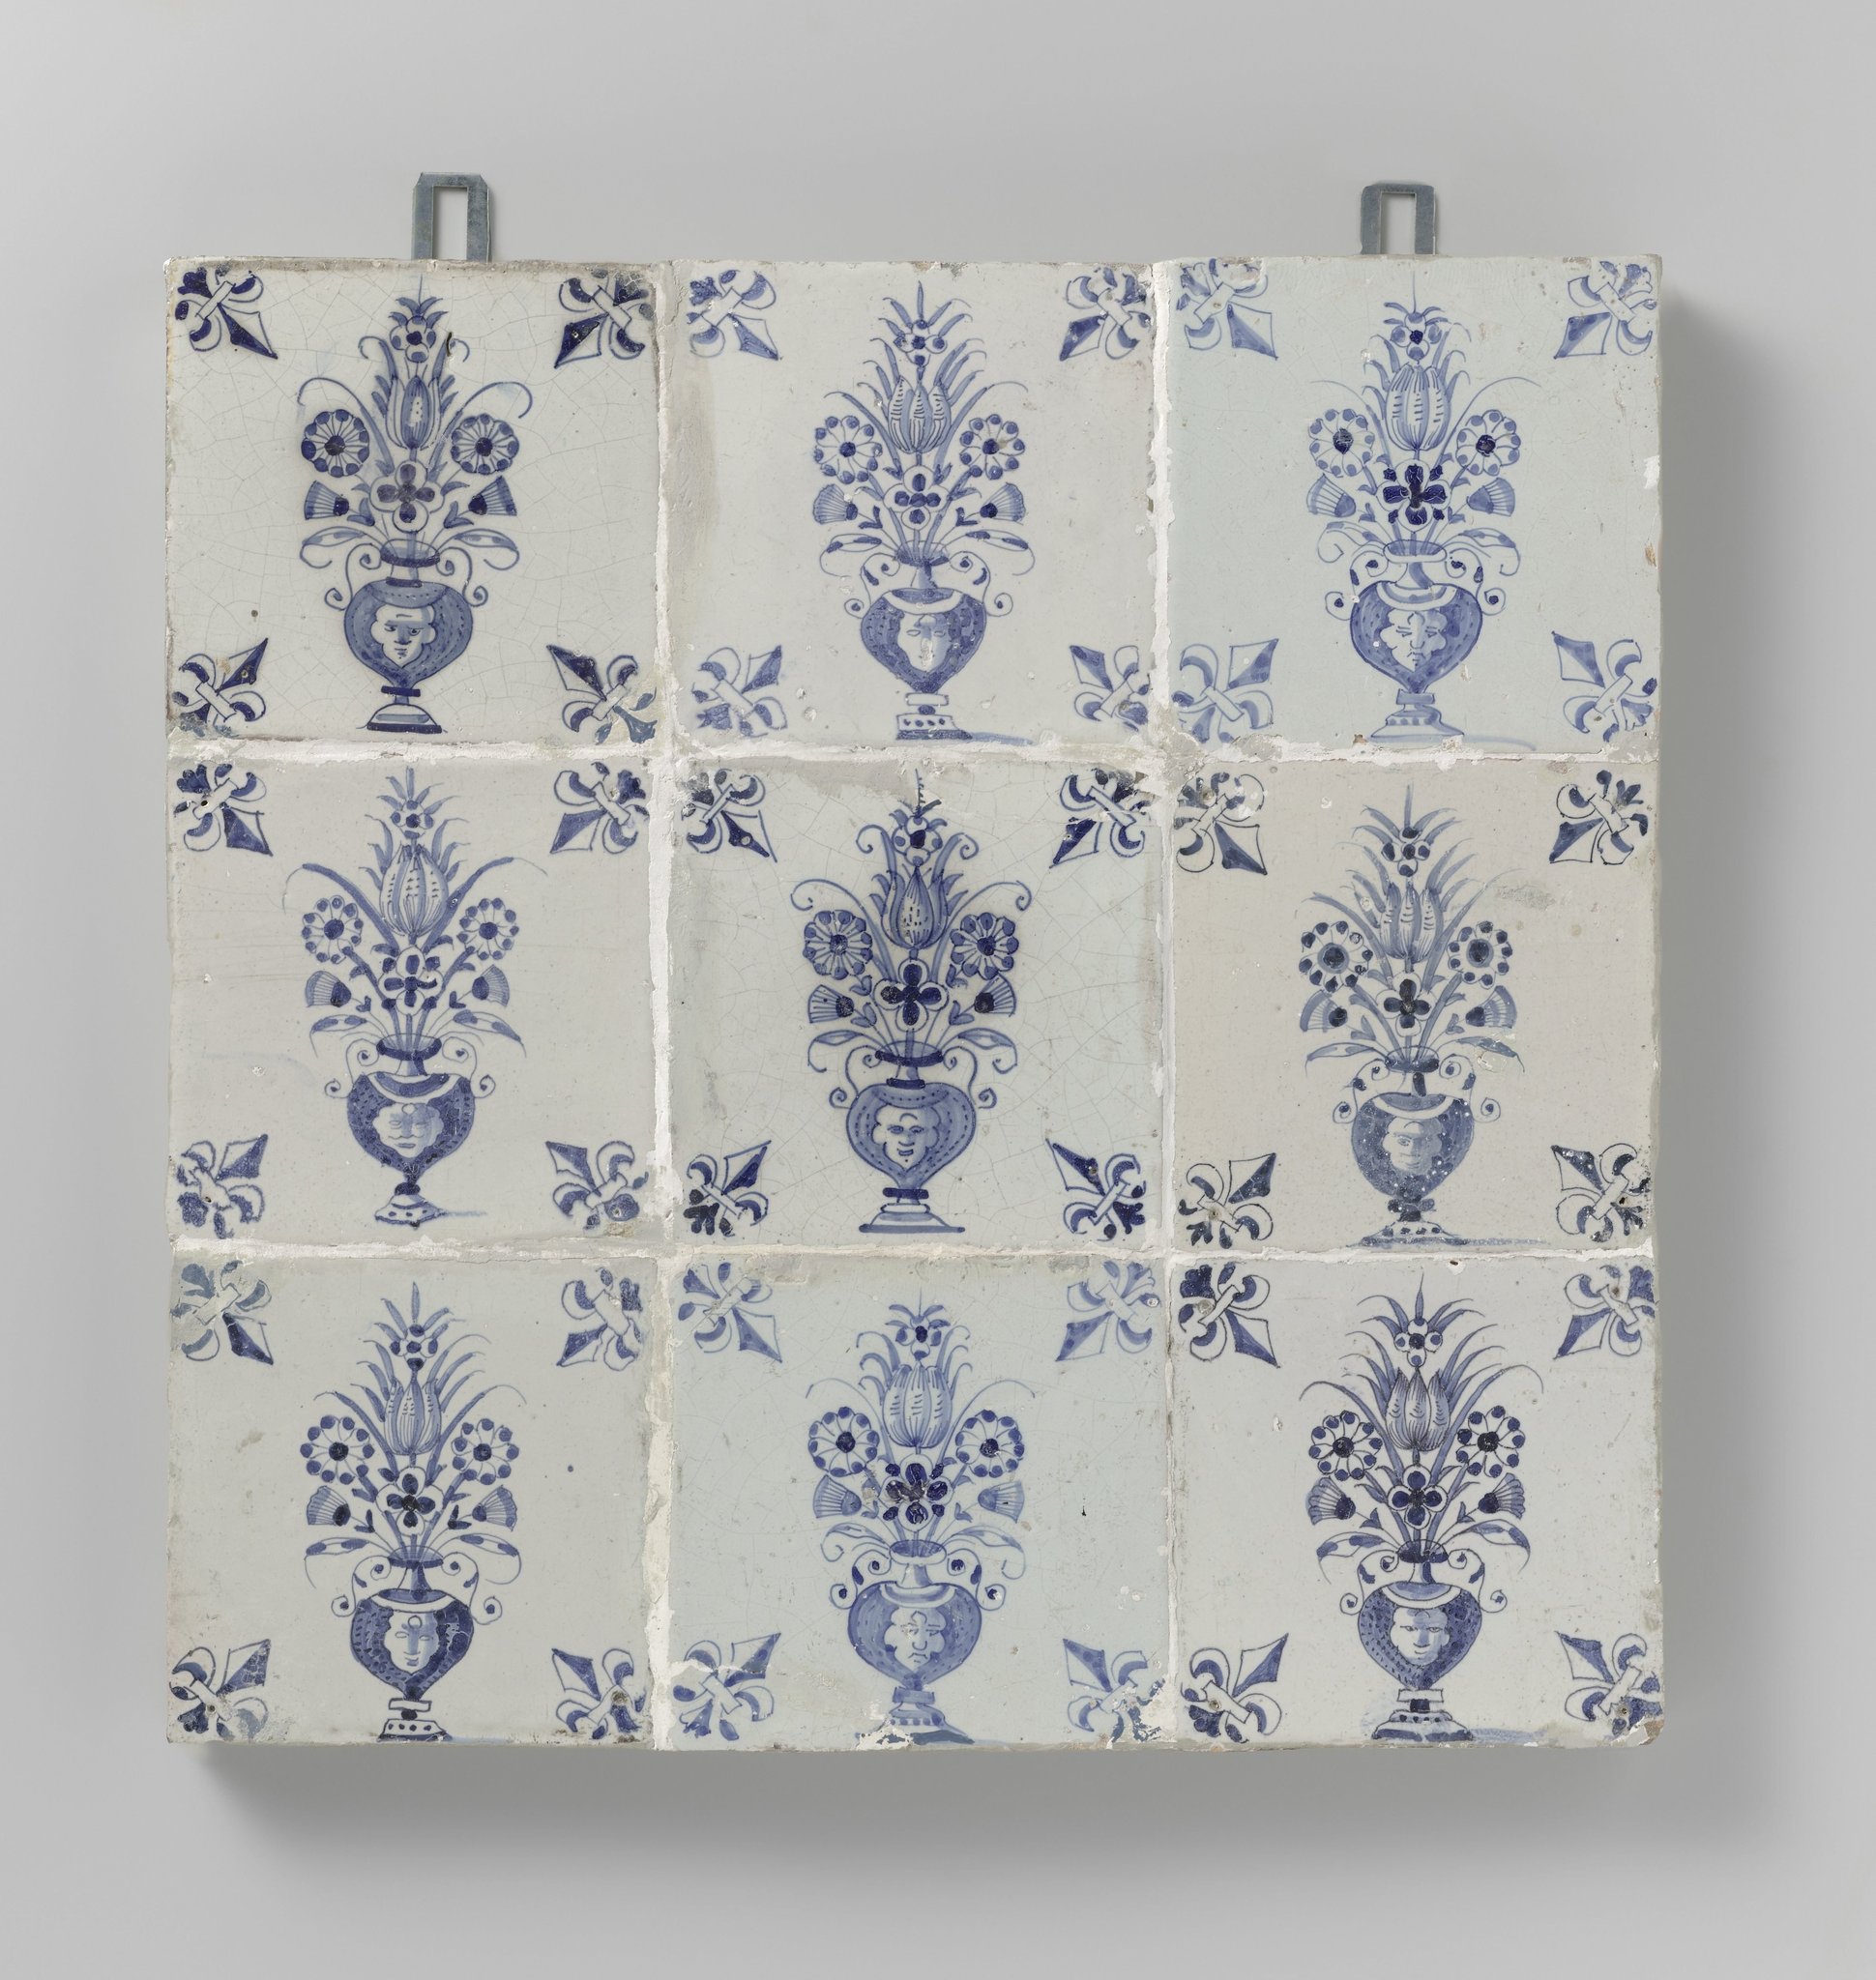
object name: tile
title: Veld van negen tegels met vazen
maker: Anonymous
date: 1640-1660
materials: earthenware, glaze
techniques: maiolica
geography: netherlands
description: Veld van negen tegels (3 x 3) elk met een blauw geschilderde vaas. In de hoeken, een lelie. Oorspronkelijk was dit een veld van 16 tegels.